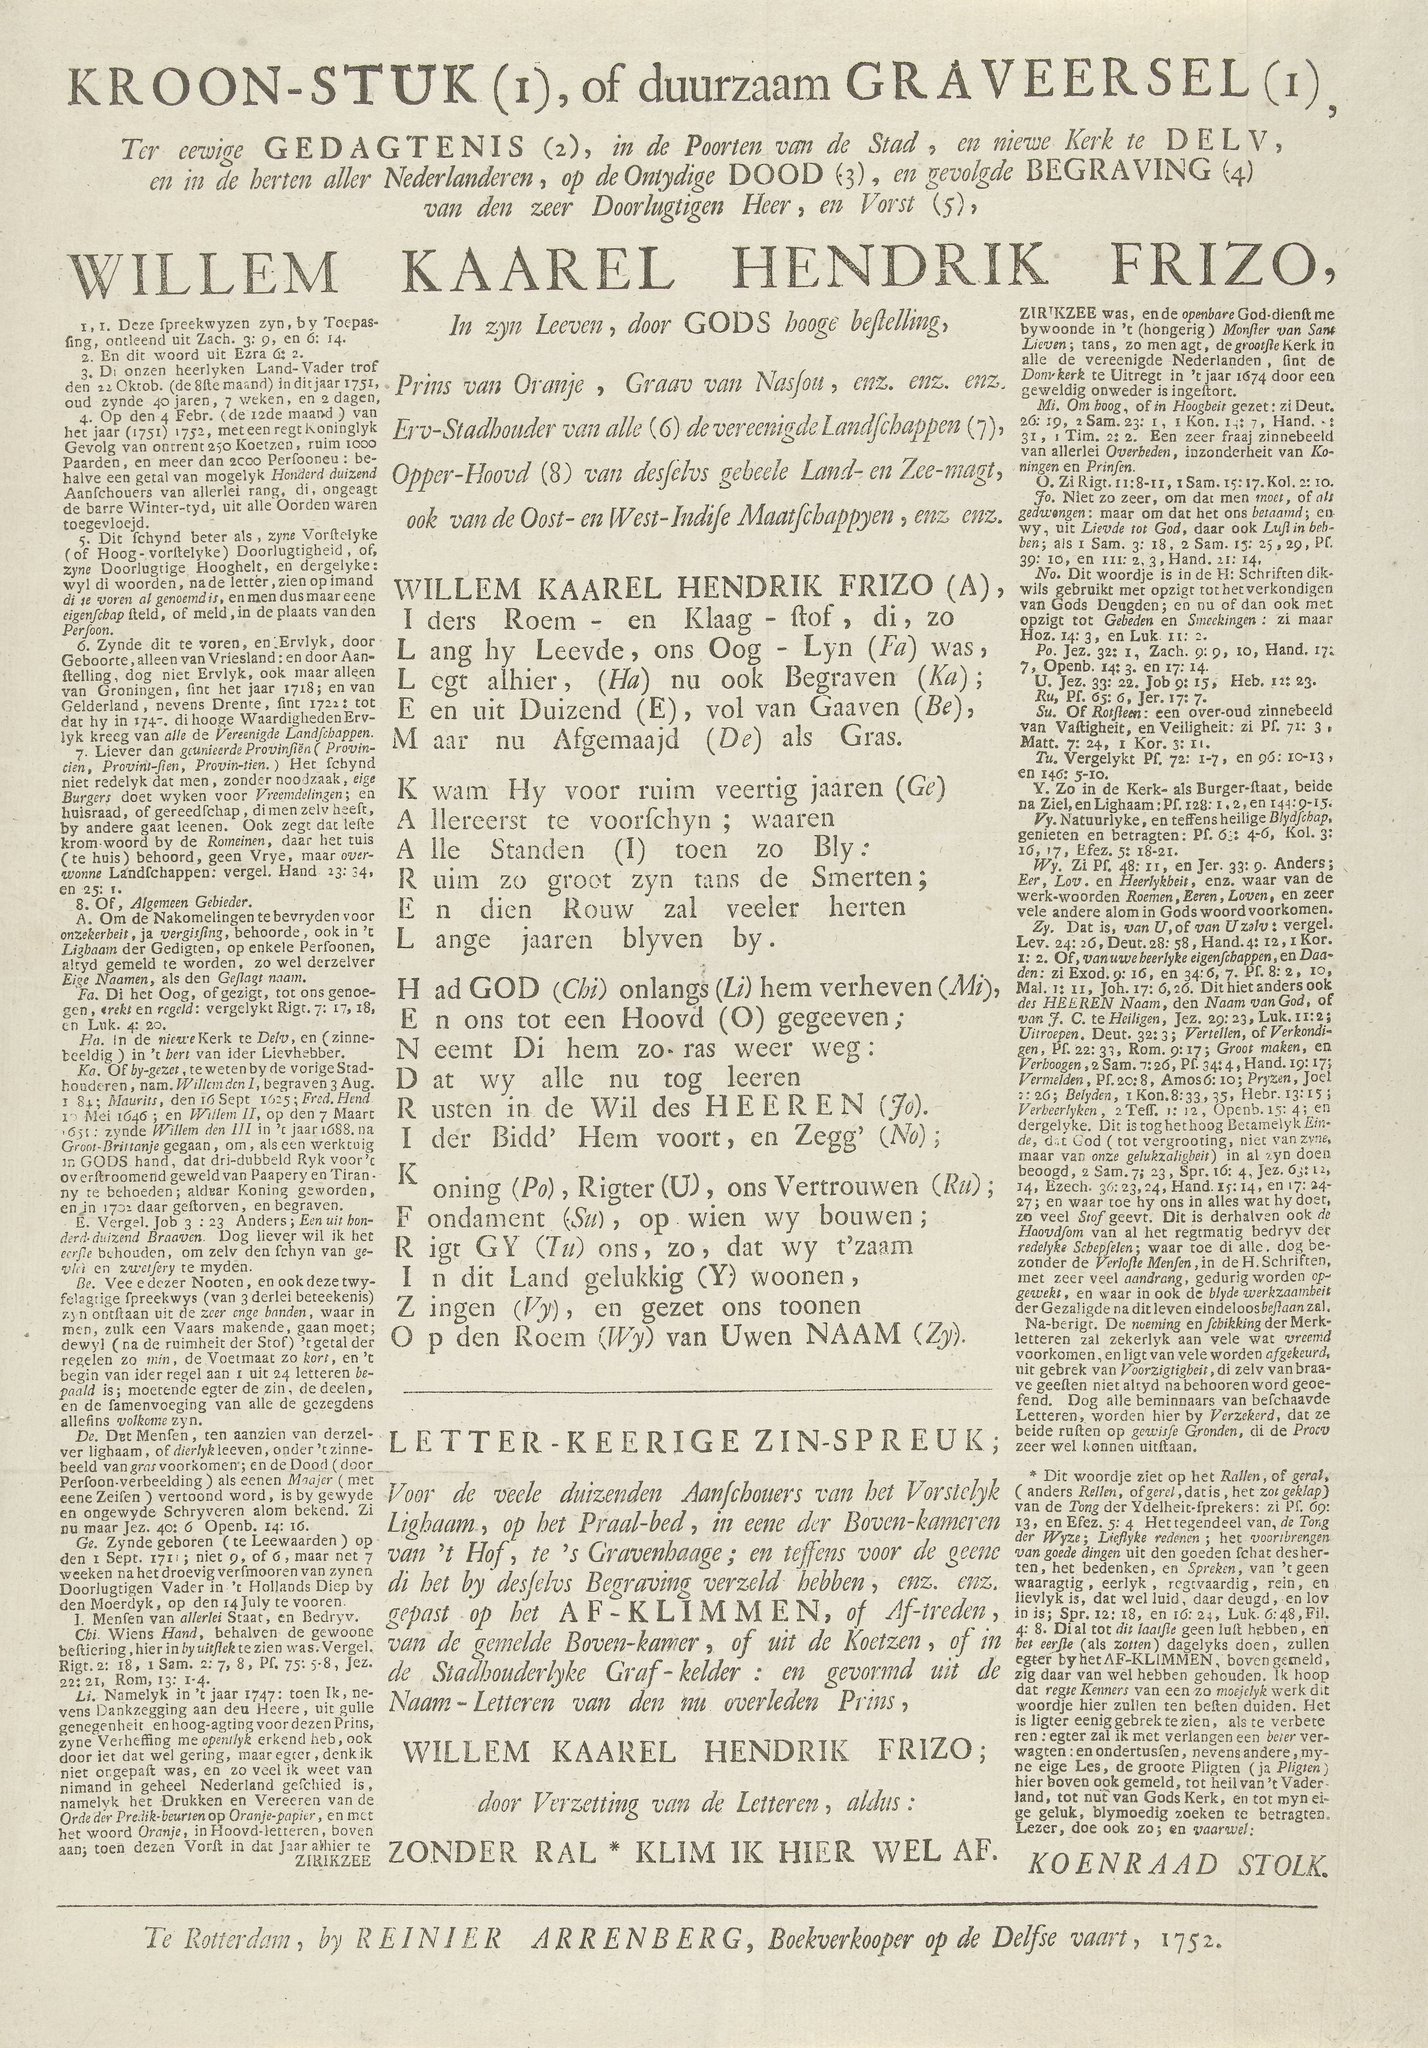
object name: text sheet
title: Kroon-stuk (I), of duurzaam Graveersel (I), Ter eewige Gedagtenis (2), in de Poorten van de Stad, en niewe Kerk te Delv, en in de herten aller Nederlanderen, op de Ontydige Dood (3), en gevolgde Begraving (4) van den zeer Doorlugtigen Heer, en Vorst (5), Willem Kaarel Hendrik Frizo (...)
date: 1752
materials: paper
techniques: letterpress printing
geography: rotterdam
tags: the hague, willem iv (prins van oranje-nassau), delft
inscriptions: collector's mark: Lugt 2228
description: Tekstblad met gedrukte spreuken, verzen en bijbelcitaten op het overlijden en de begrafenis van prins Willem IV te Delft op 4 februari 1752.